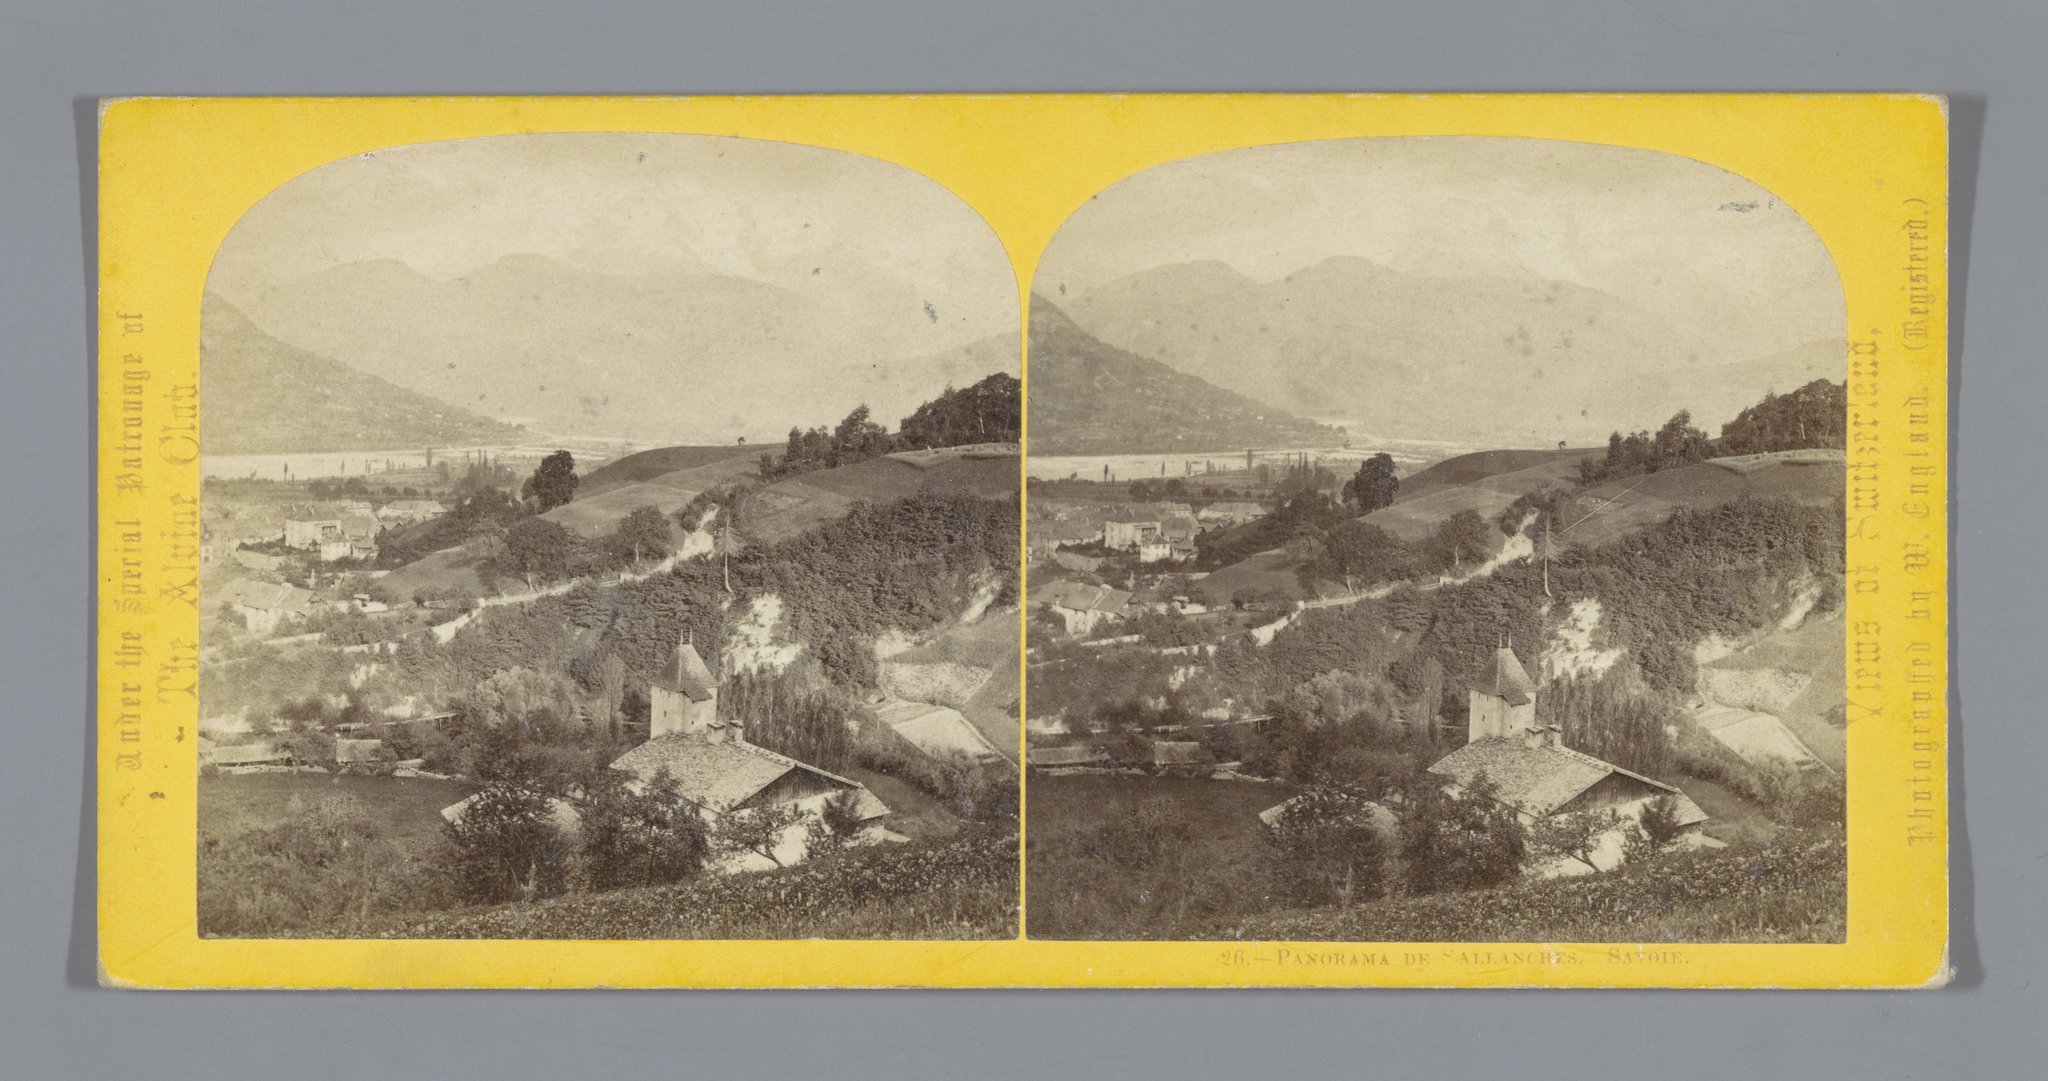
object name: stereograph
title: Gezicht op Sallanches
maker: william england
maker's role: fotograaf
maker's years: 1816-1896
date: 1850-1880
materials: cardboard, photographic support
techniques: albumen print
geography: bonneville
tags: city-view in general; 'veduta'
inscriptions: inscription: ‘Views of Switzerland, photographed by W. England. (Registered) Under the Special Patronage of the Alpine Club.’, number: ‘26.’